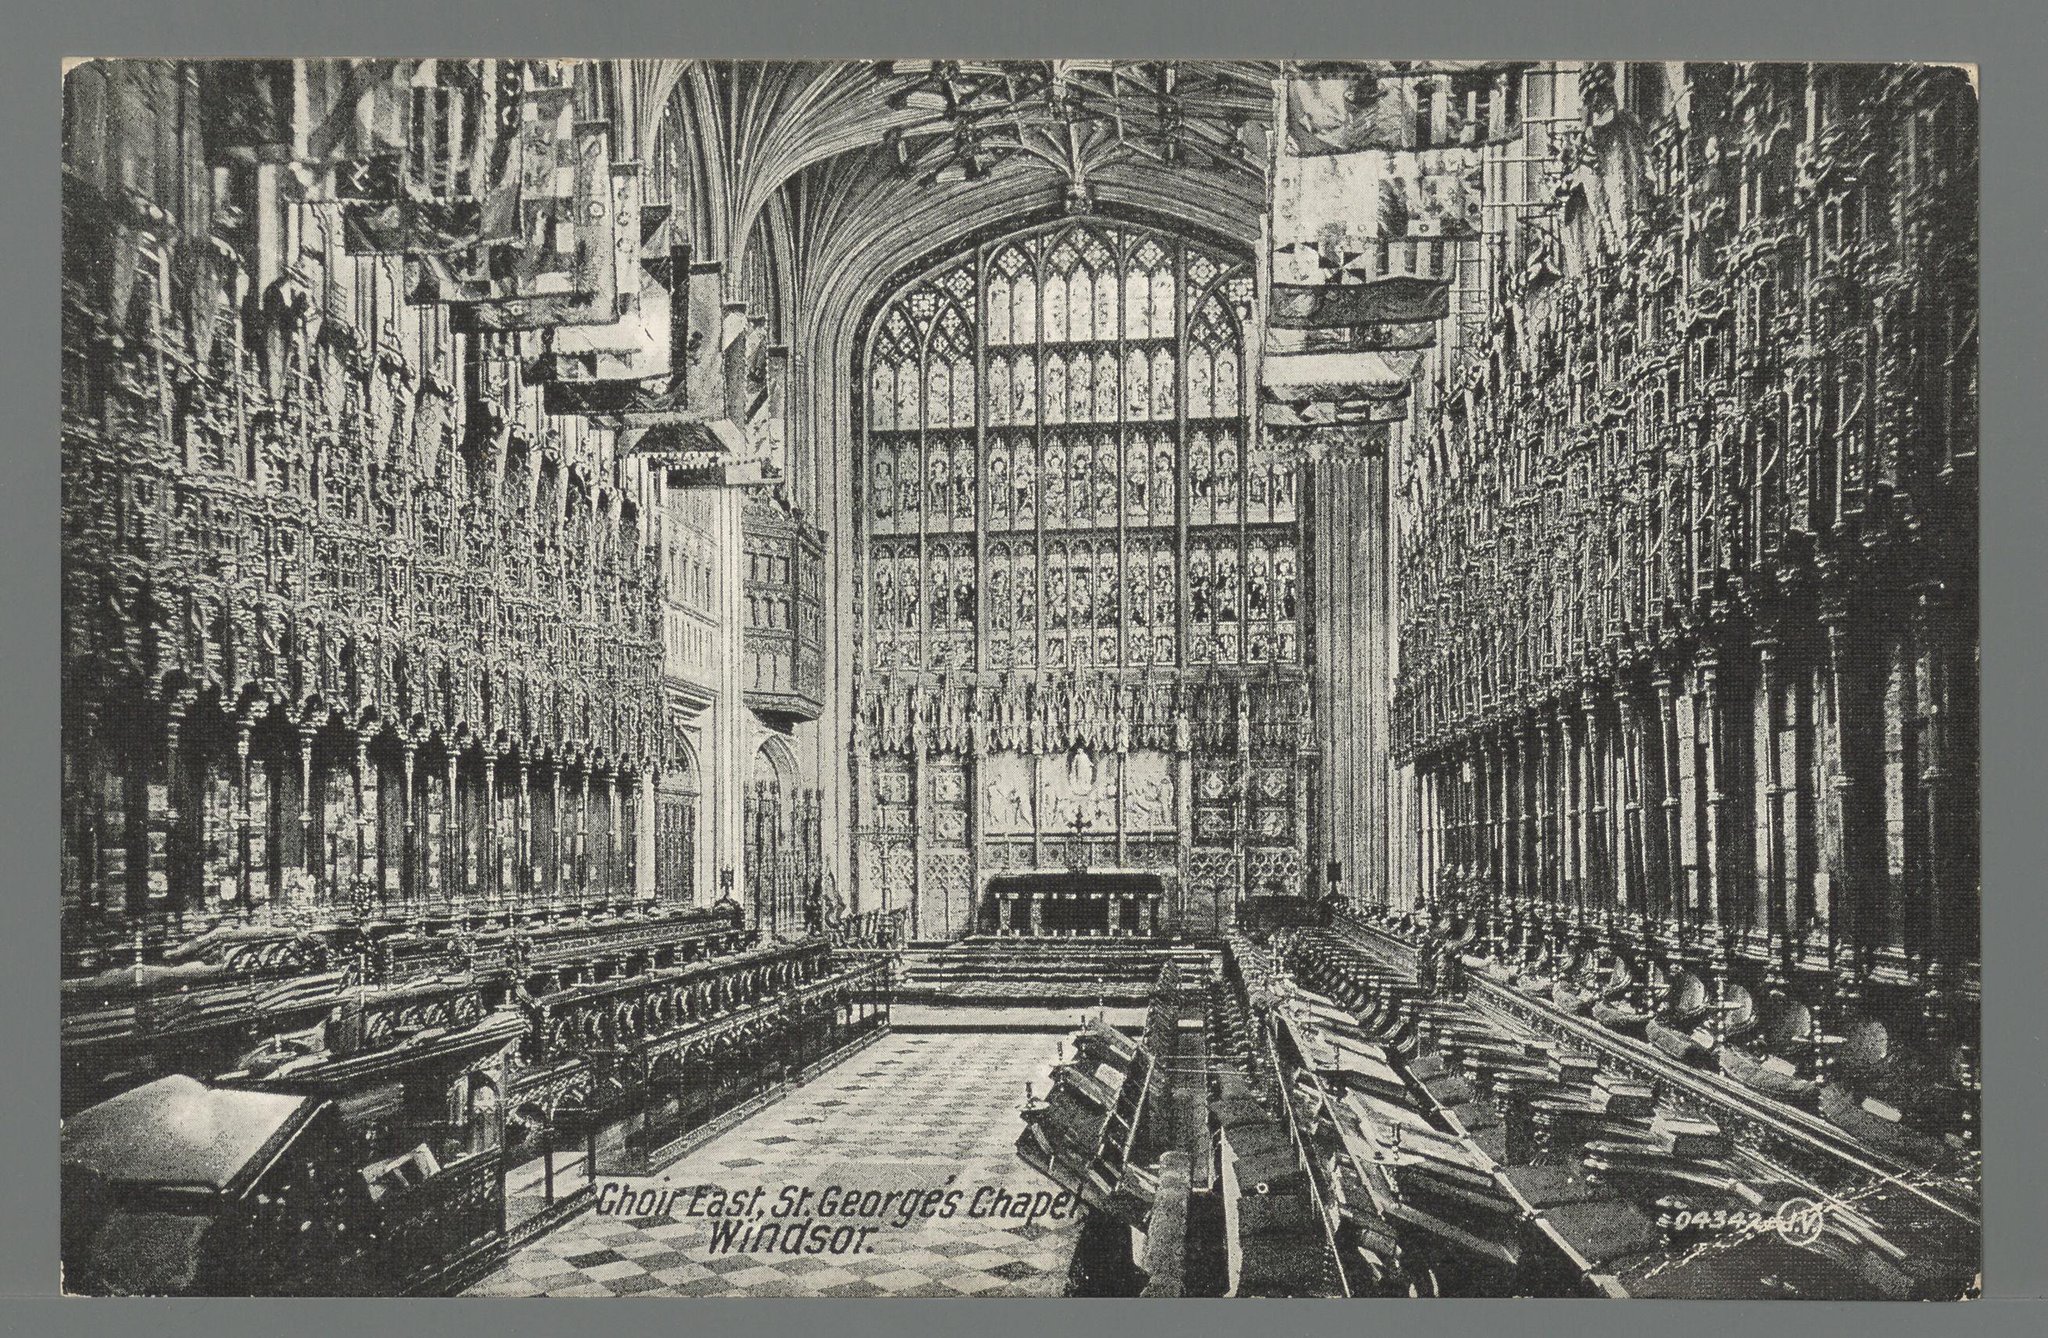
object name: photomechanical print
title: Choir East, St. George's Chapel. Windsor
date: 1902-1930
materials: cardboard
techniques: autotype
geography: great britain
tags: church (exterior) - qq - small church, chapel, parts of church interior: choir